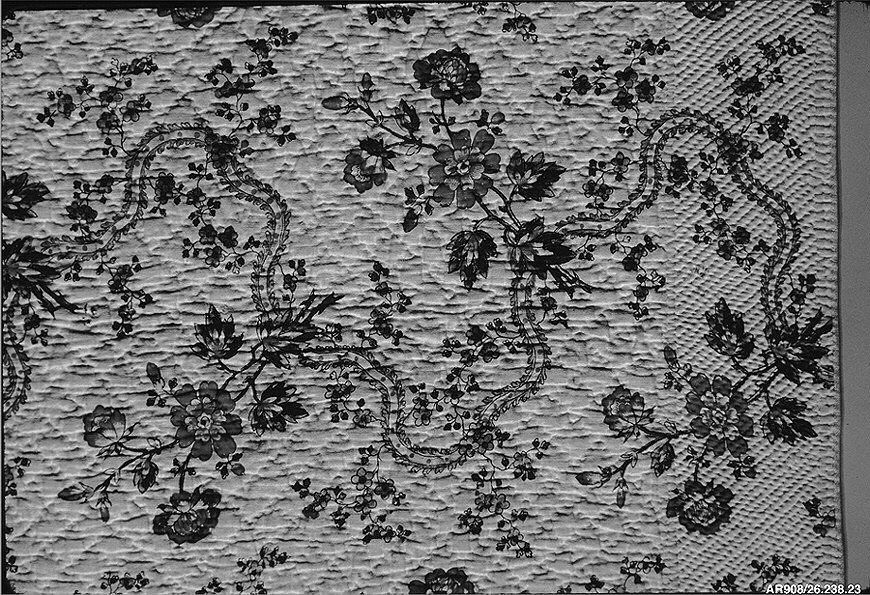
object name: fragment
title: Petticoat fragment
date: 1783-1789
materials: cotton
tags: flowers,leaves